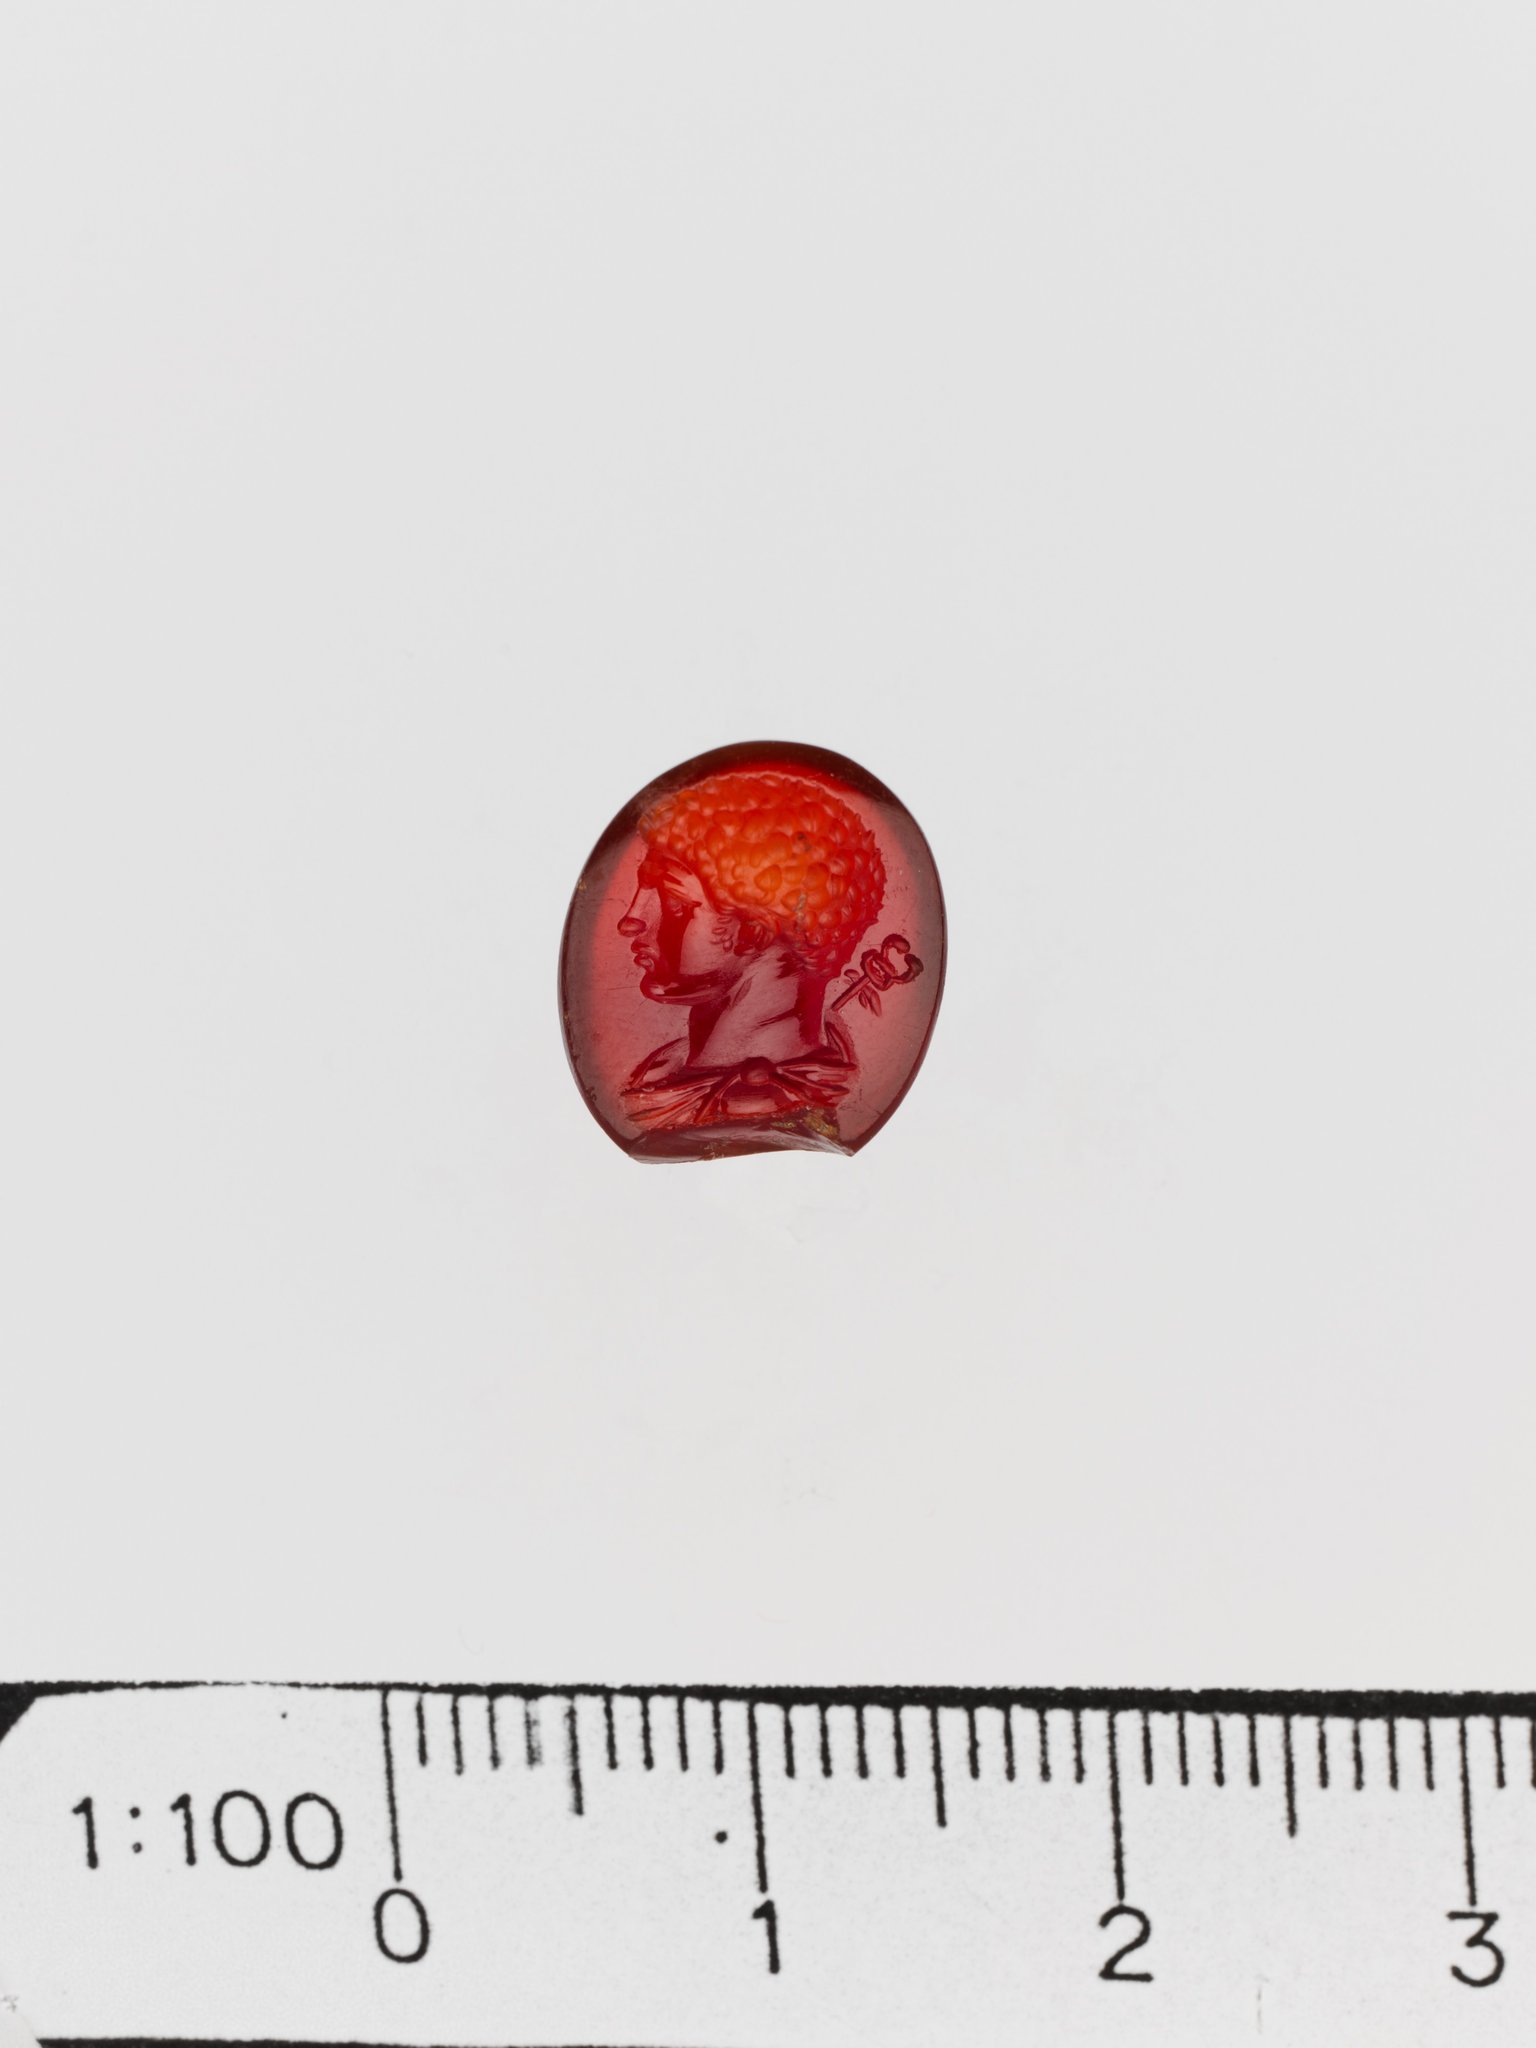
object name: intaglio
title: Carnelian ring stone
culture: roman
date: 100 BCE-300 CE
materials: gemstone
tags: profiles,hermes